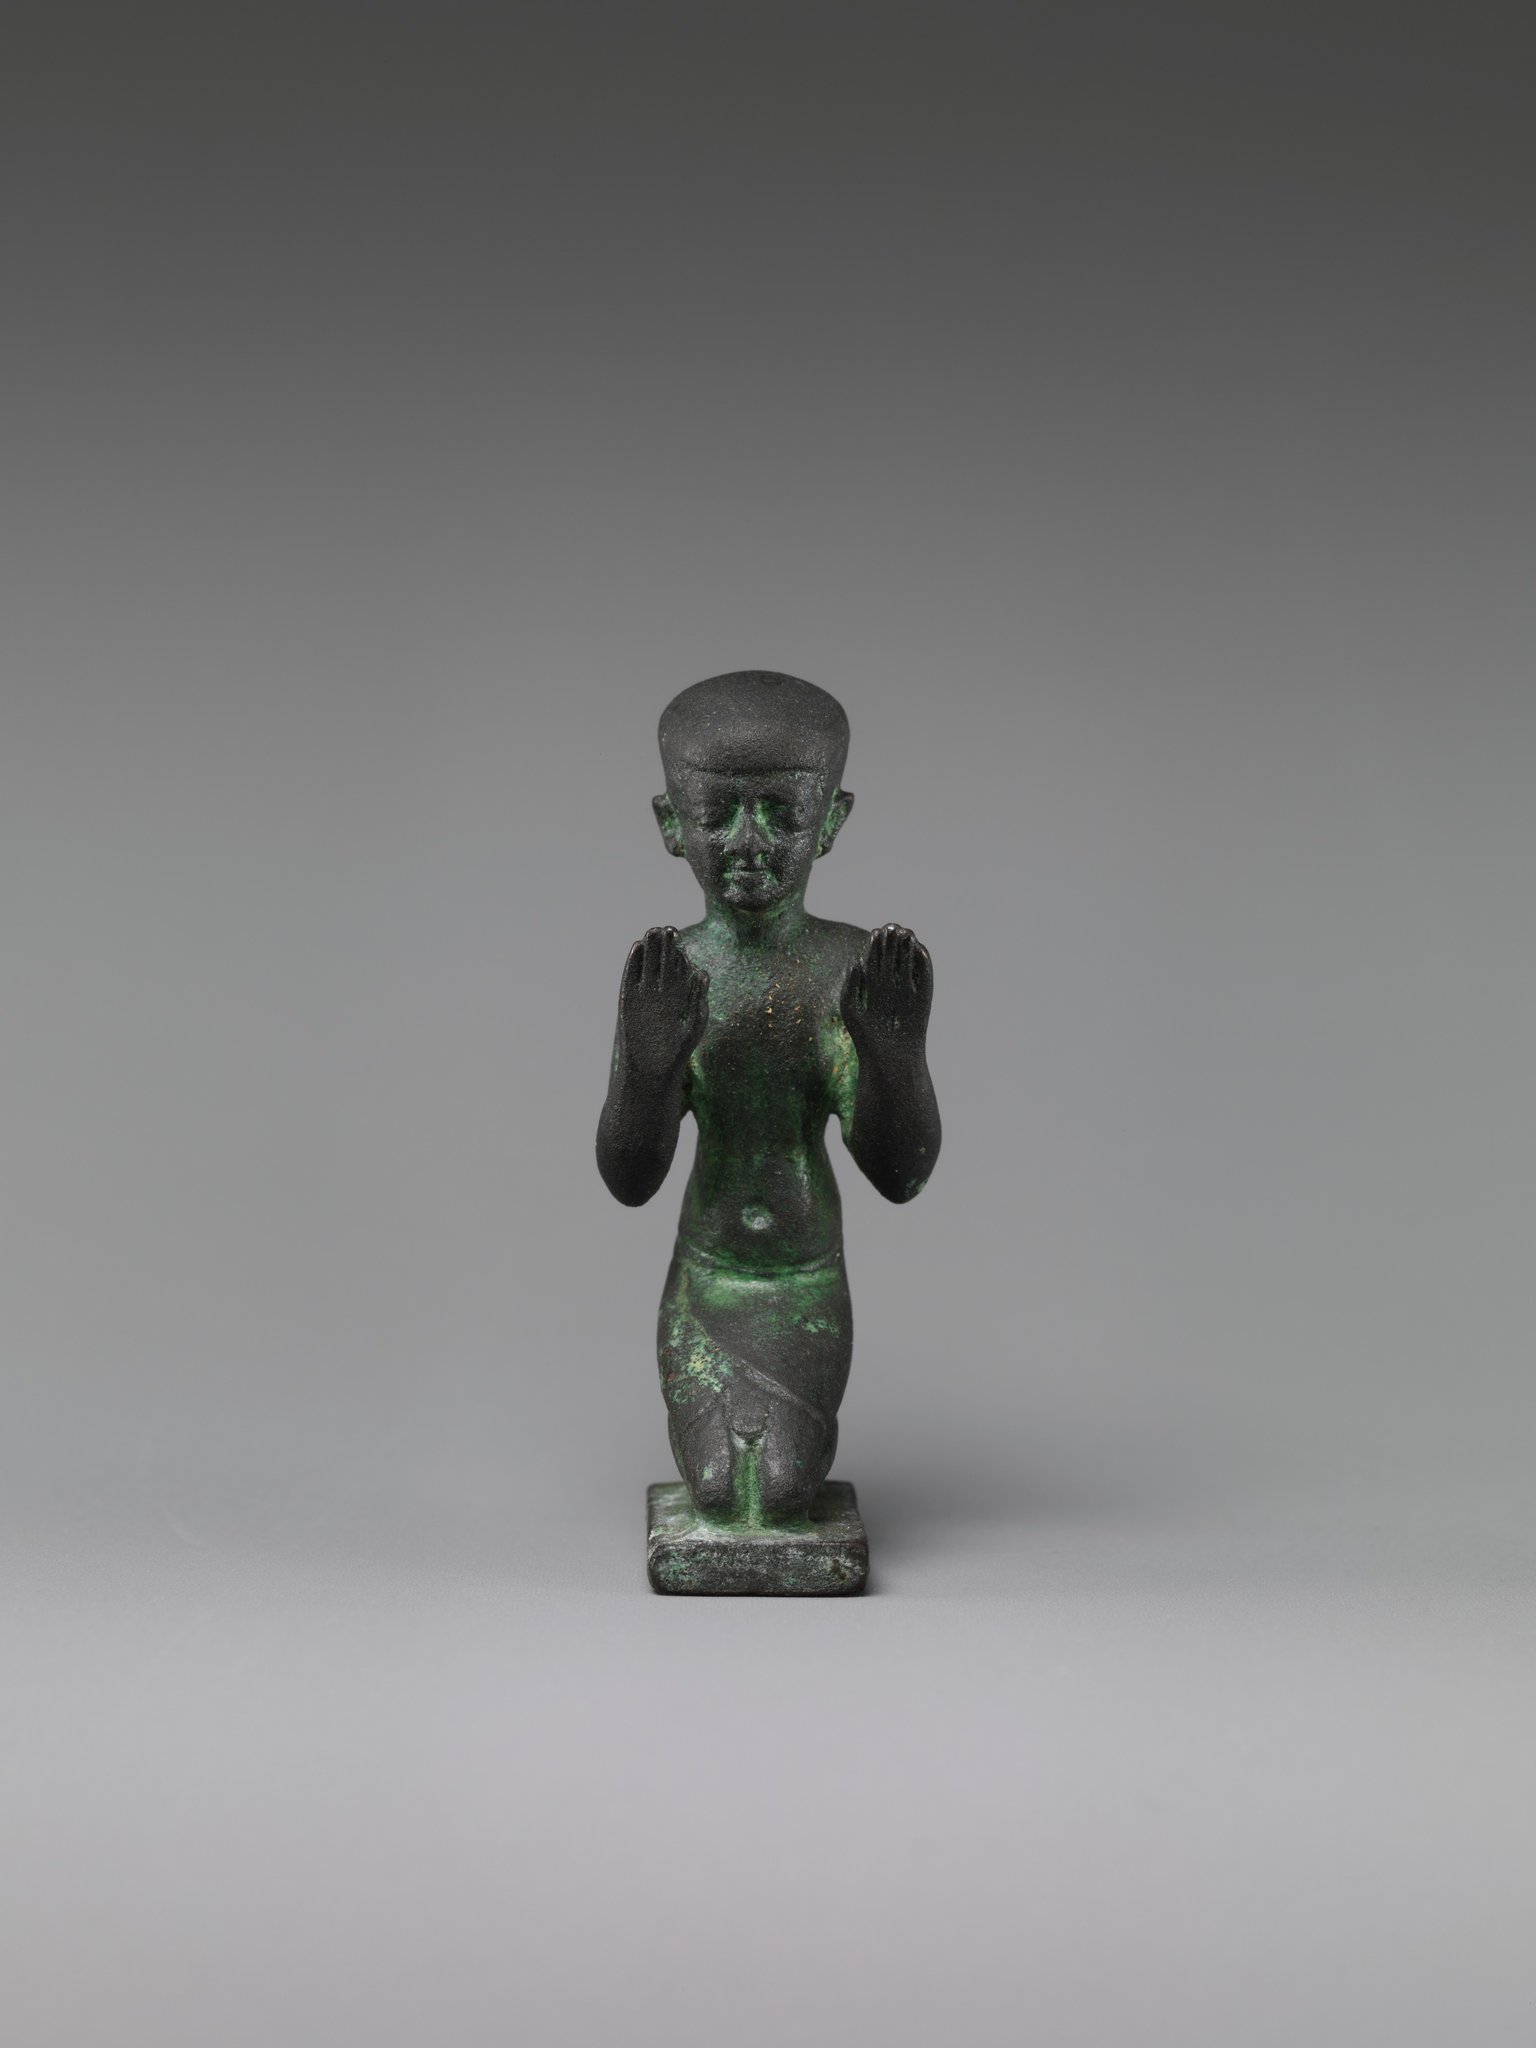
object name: statuette, devotee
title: Statuette of an adorant from a group with a god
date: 332-330 BCE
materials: metal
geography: egypt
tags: men